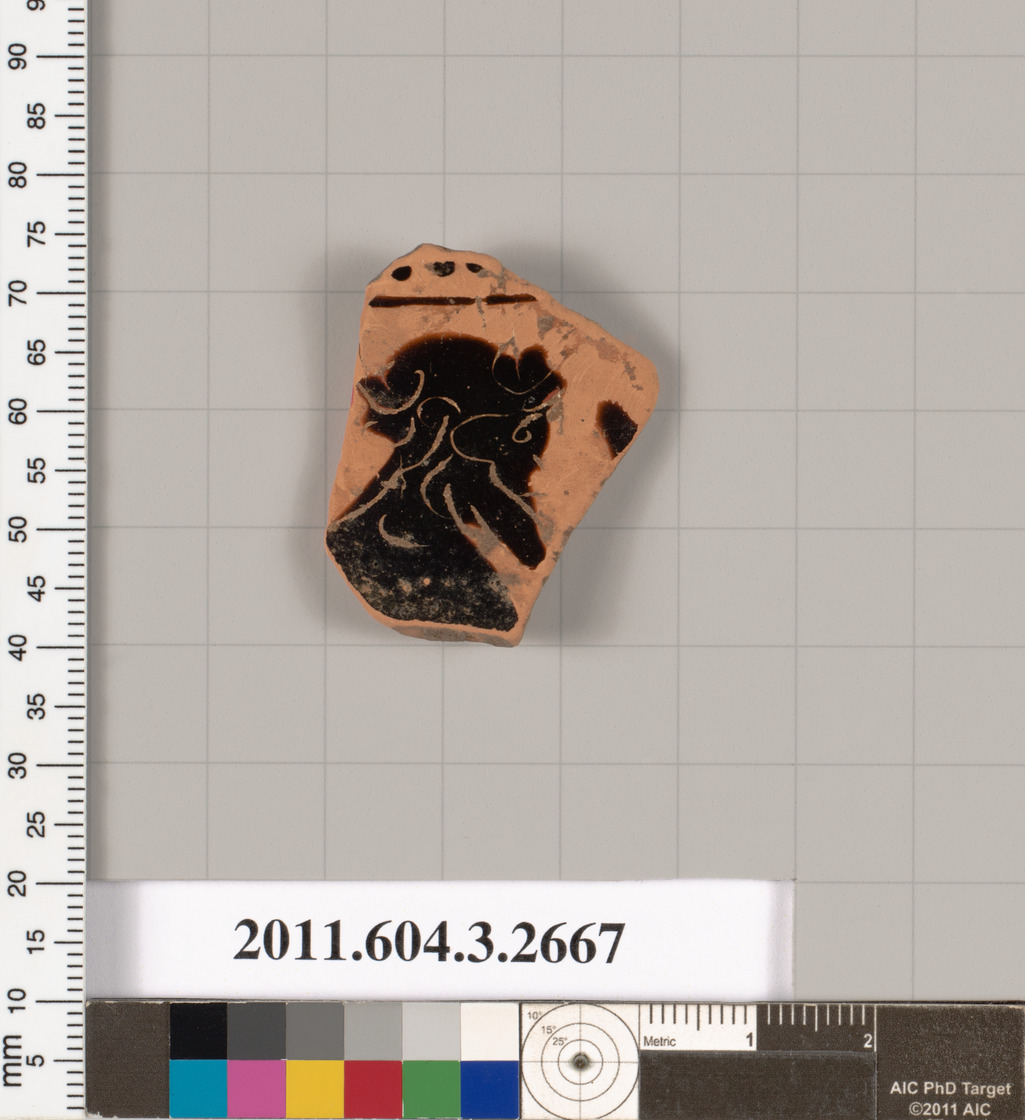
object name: olpe fragment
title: Terracotta fragment of an olpe (jug)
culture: greek, attic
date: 534-468 BCE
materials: terracotta